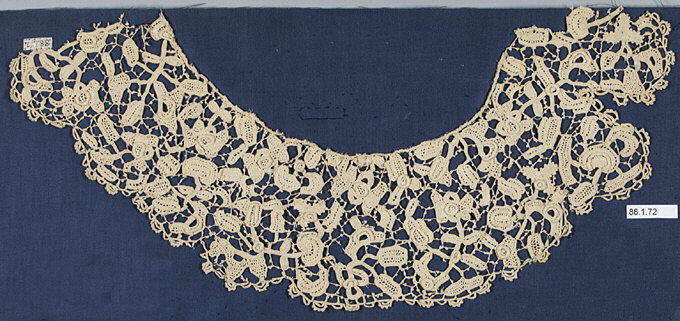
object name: collar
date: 1850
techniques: crochet